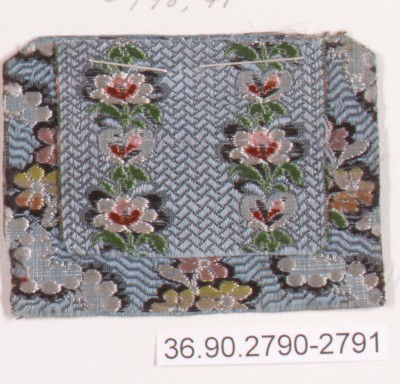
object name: piece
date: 1801-1900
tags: flowers